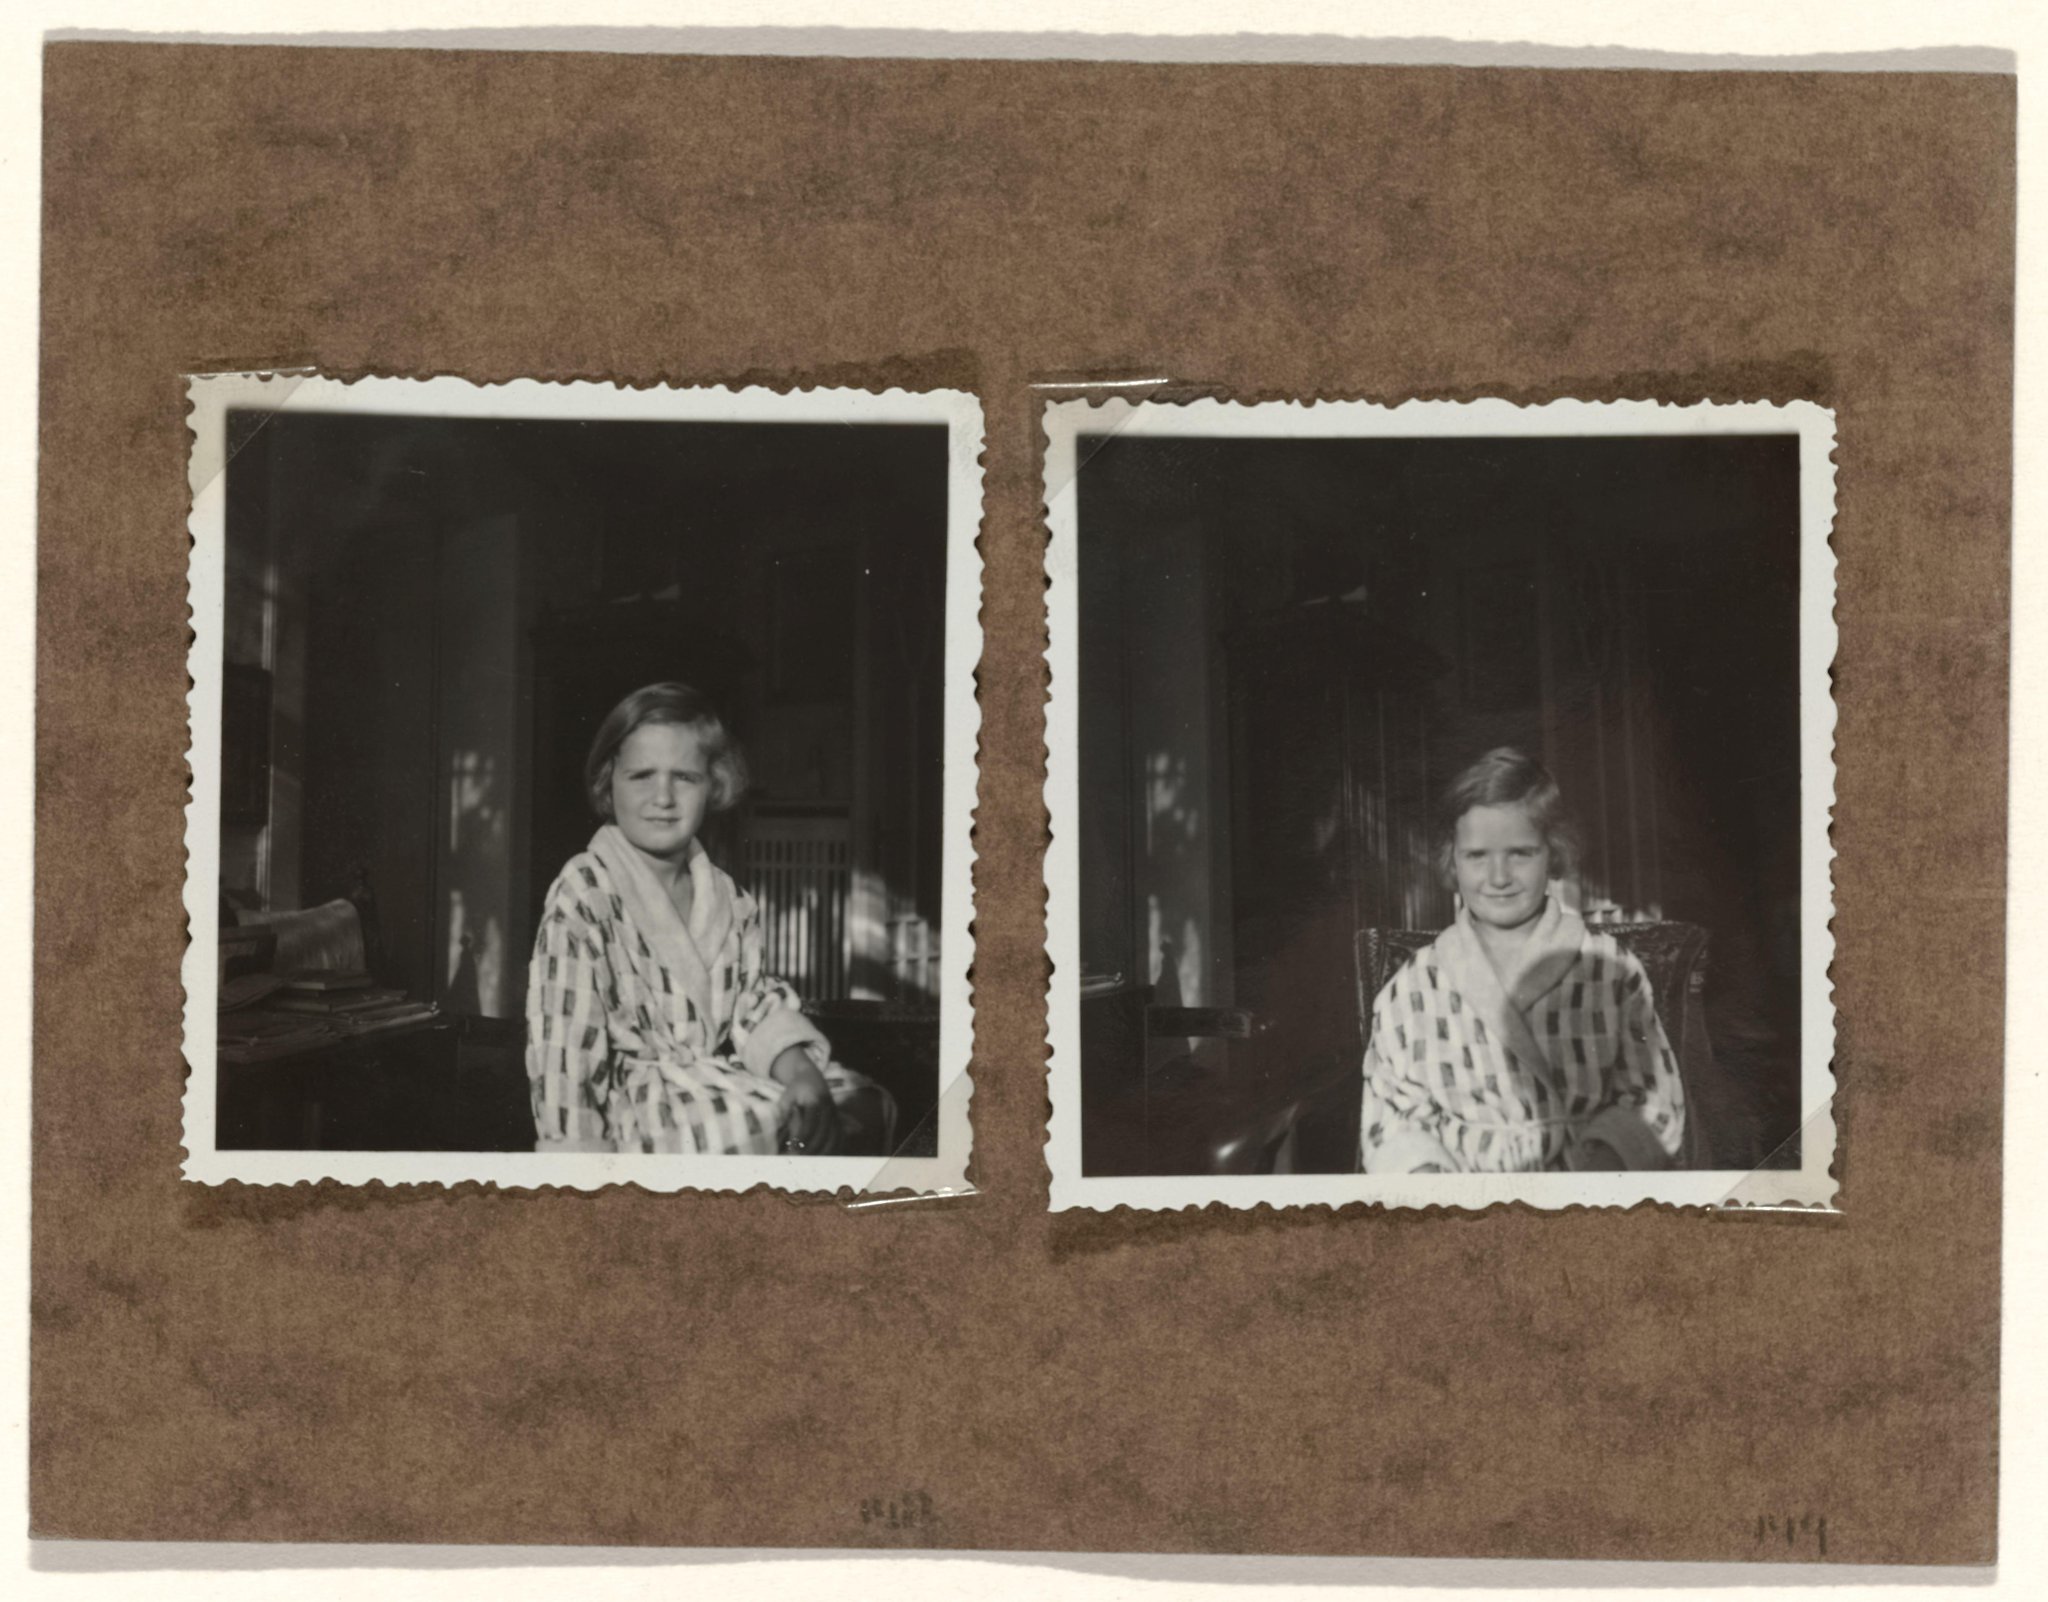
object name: photograph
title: Isabel Wachenheimer in een gestreepte ochtendjas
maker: Anonymous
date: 1931-1937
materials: photographic support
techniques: gelatin silver print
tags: leiden, isabel wachenheimer-elon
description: Isabel Wachenheimer in een gestreepte ochtendjas.